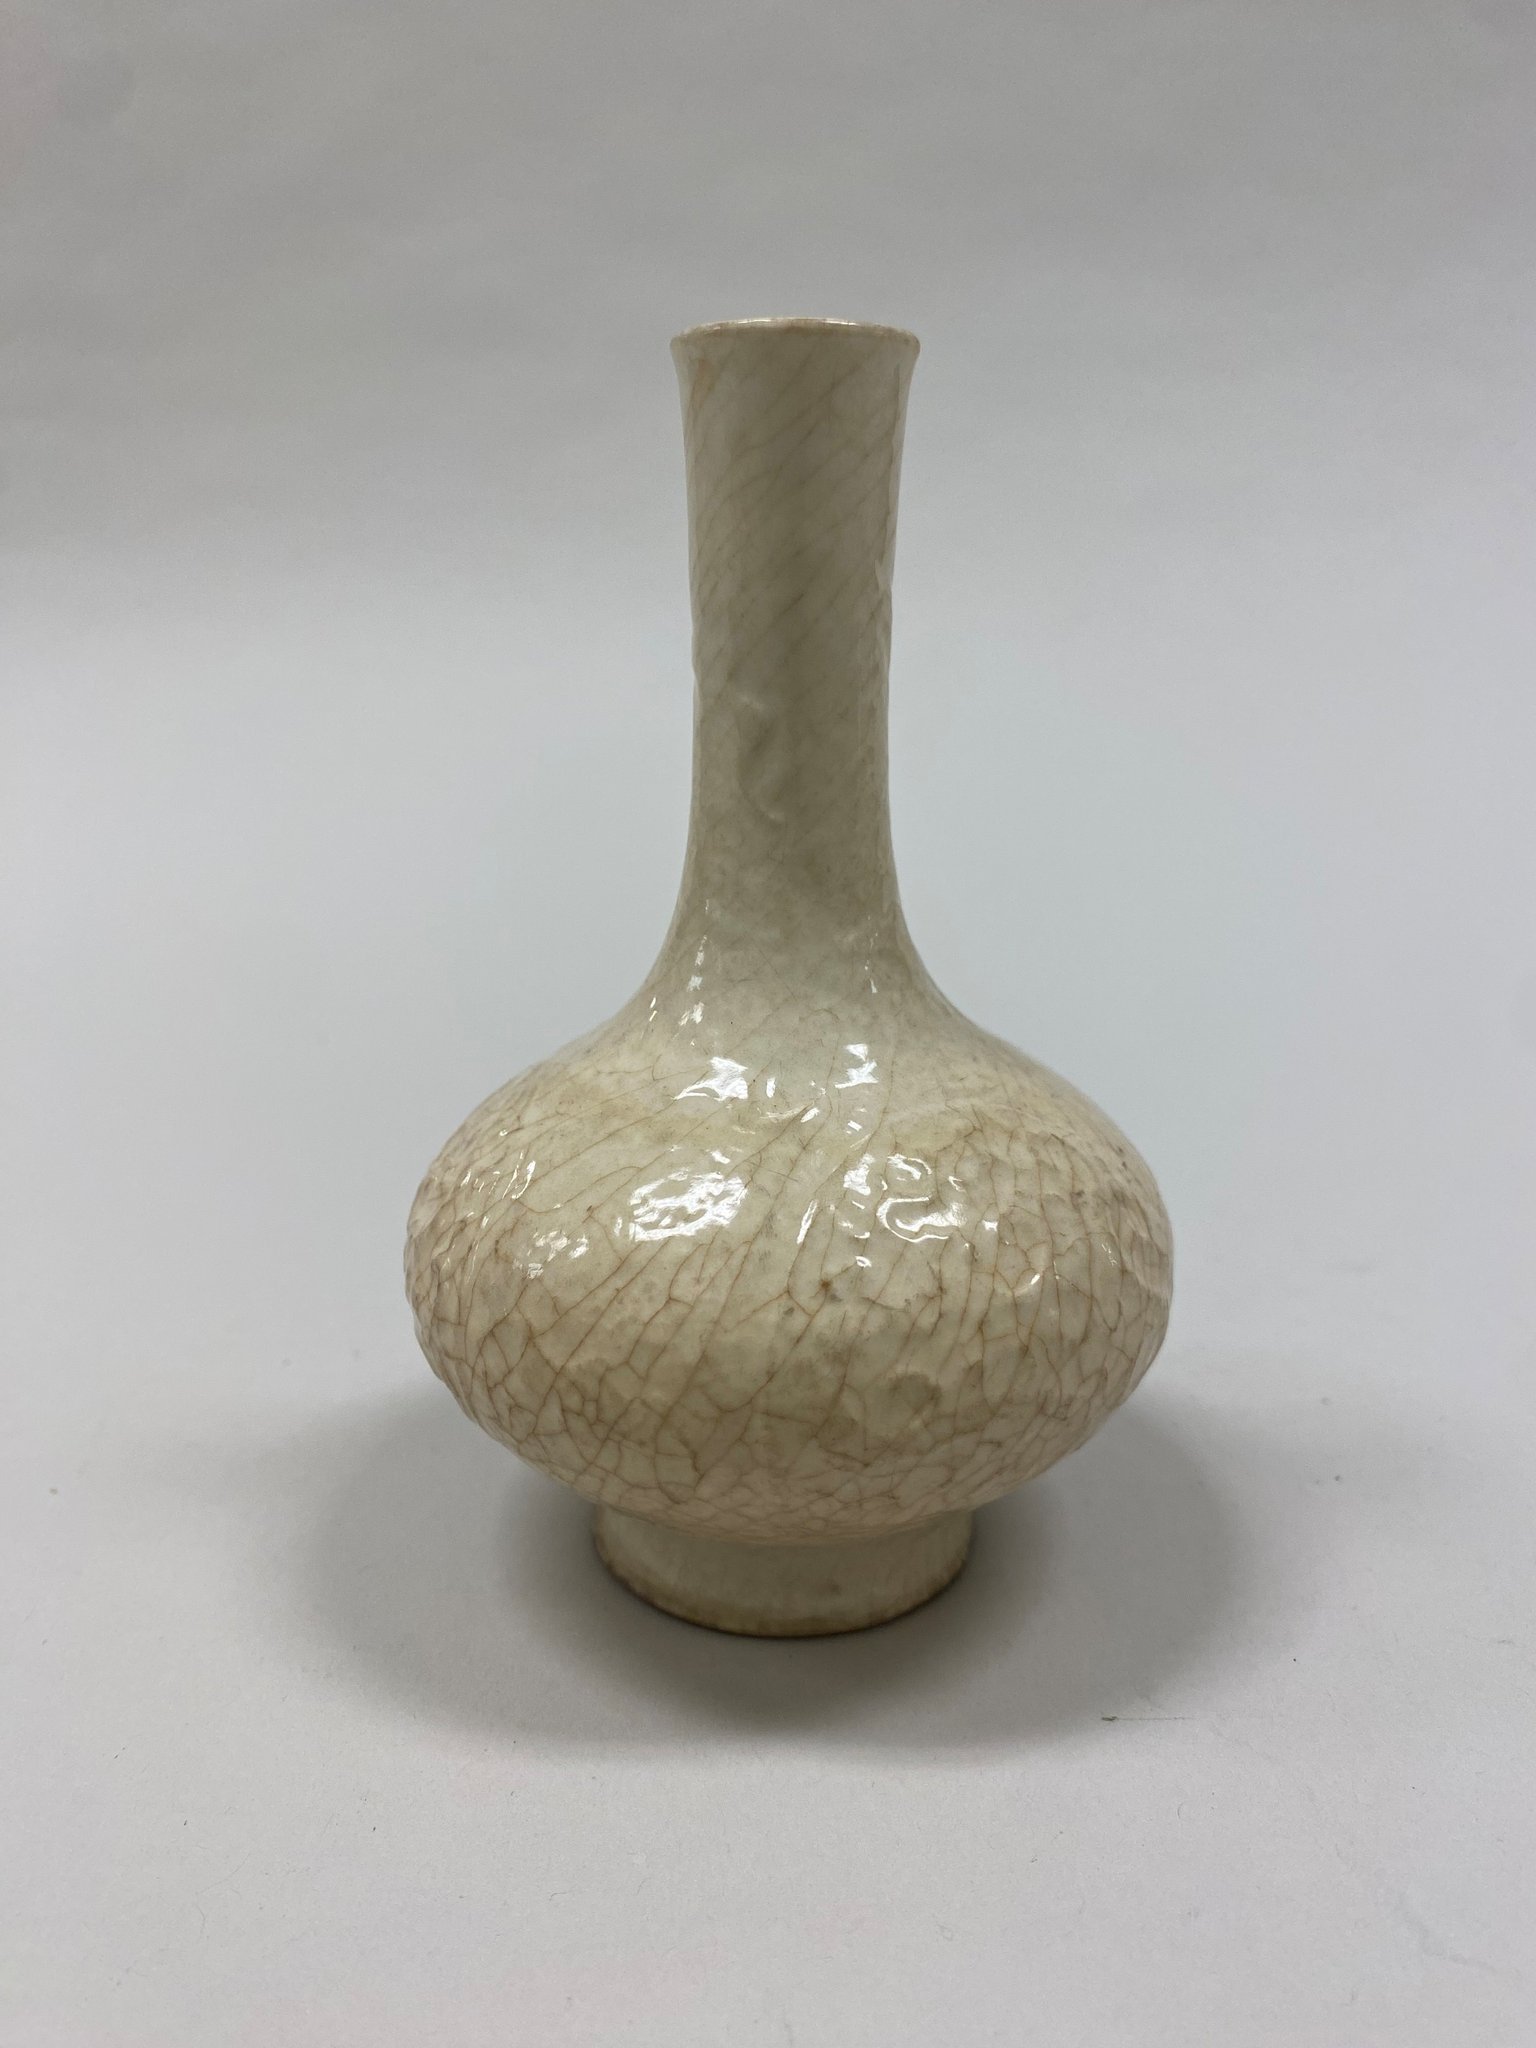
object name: bottle vase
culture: chinese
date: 1701-1800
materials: glaze, porcelain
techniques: molding